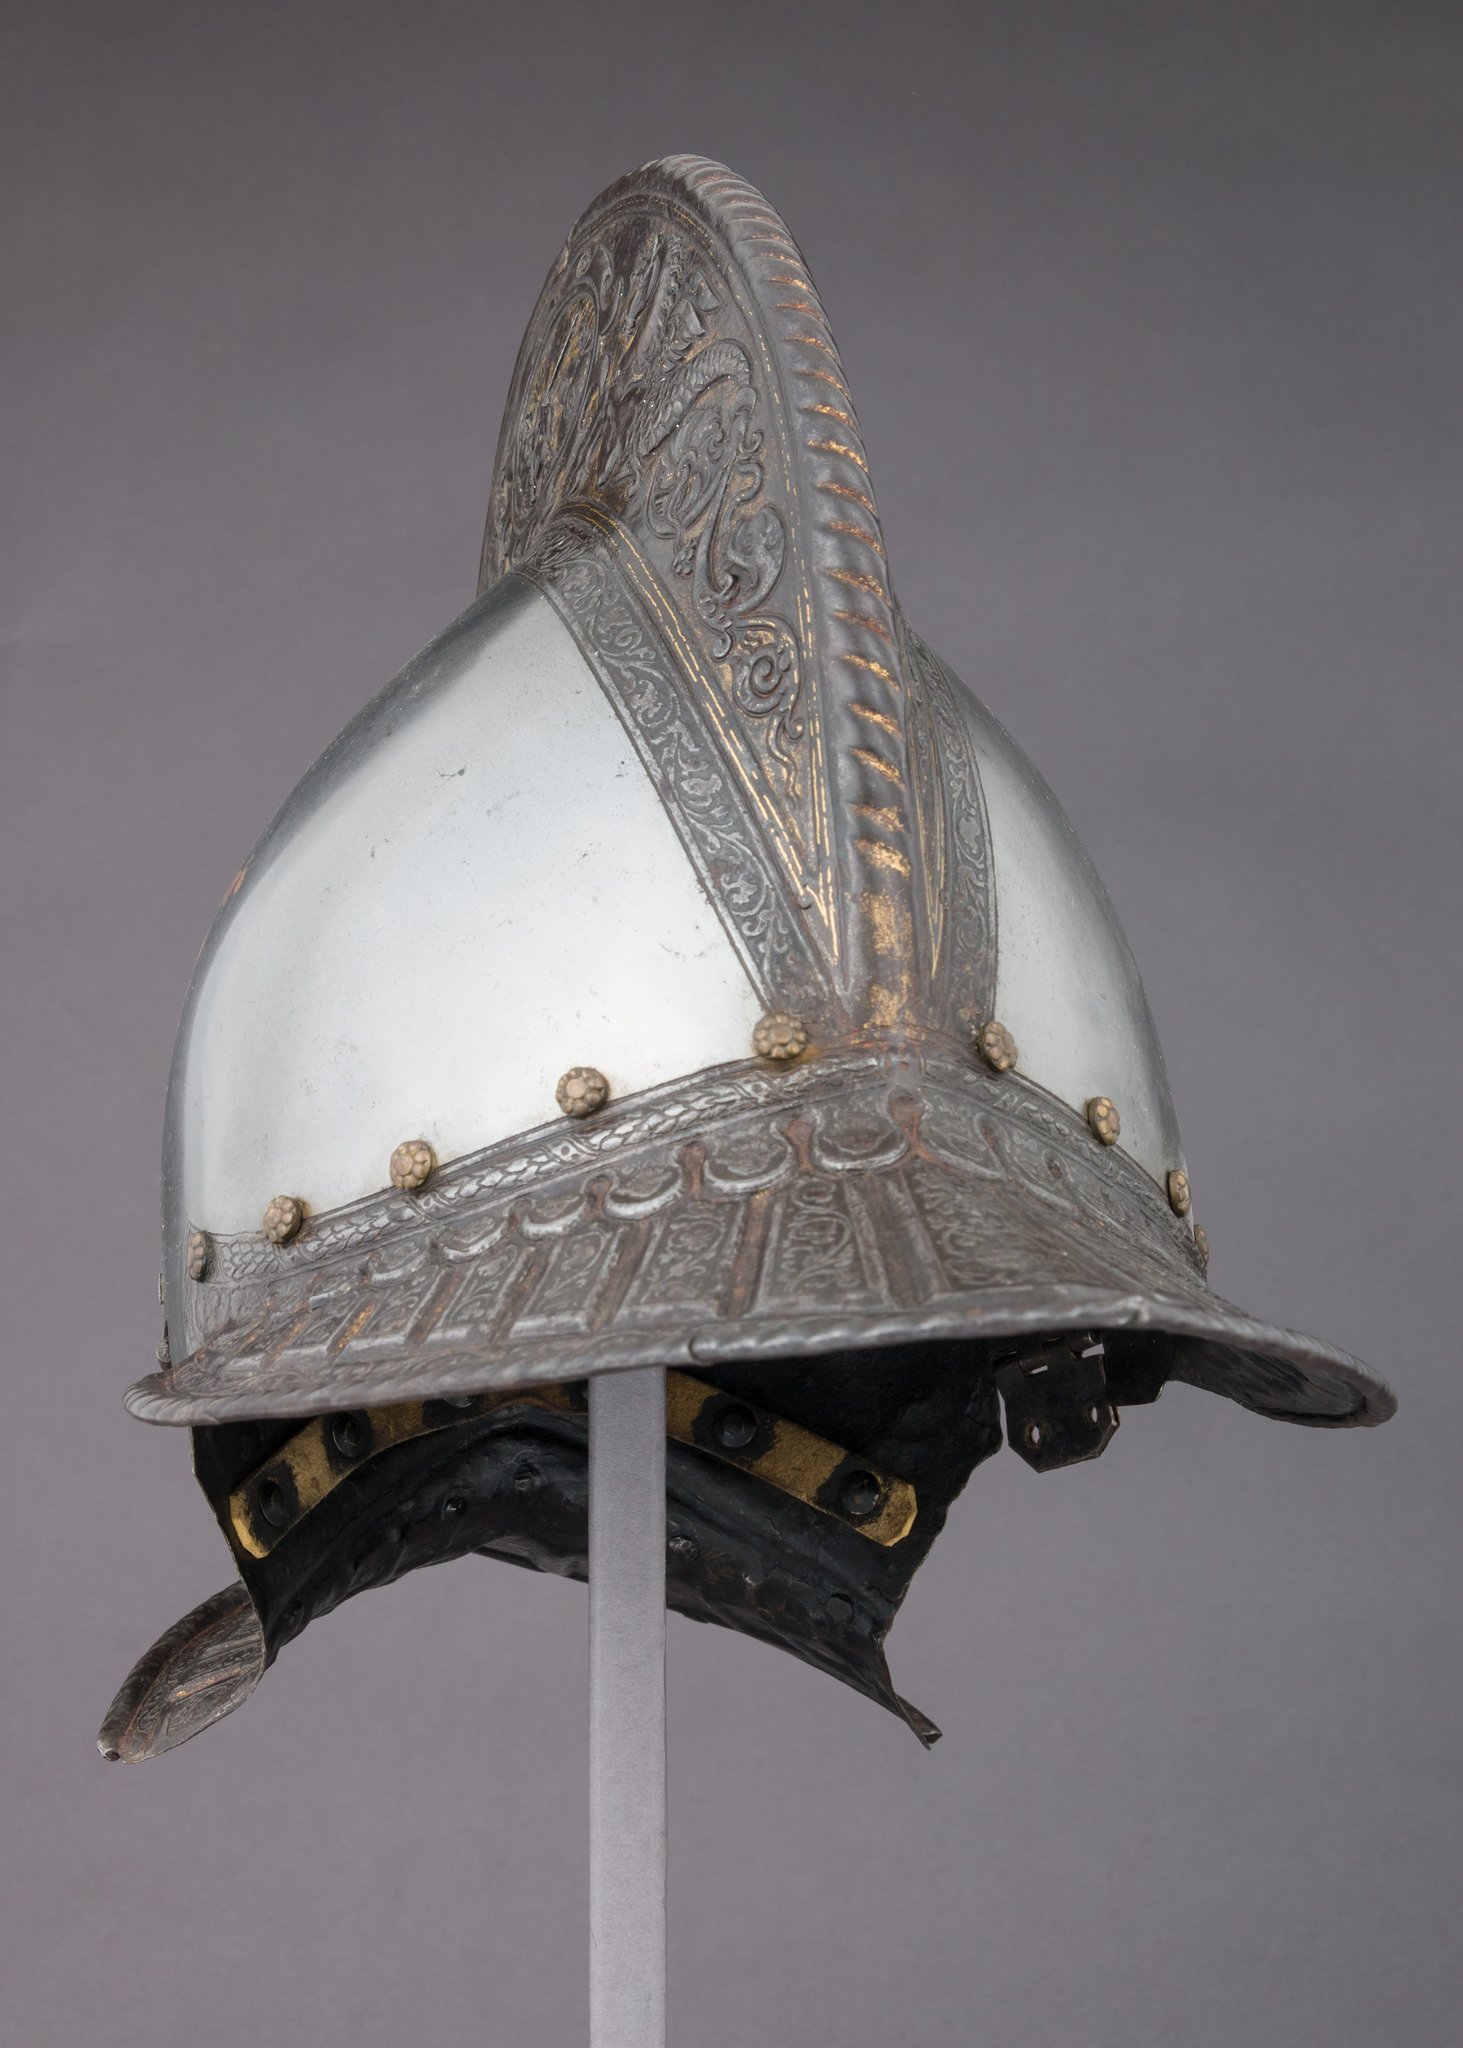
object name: burgonet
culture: french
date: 1550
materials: brass, gold, leather, steel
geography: france